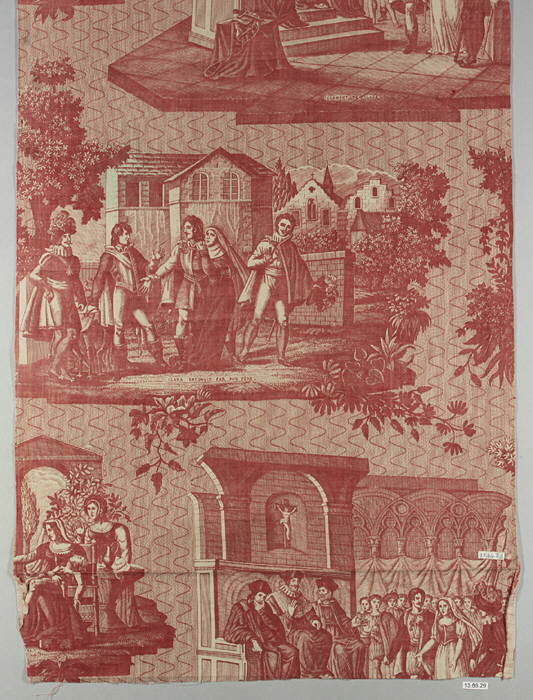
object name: furnishing textile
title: The Judgment of Clare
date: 1815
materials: cotton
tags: houses,men,women,trees,christ